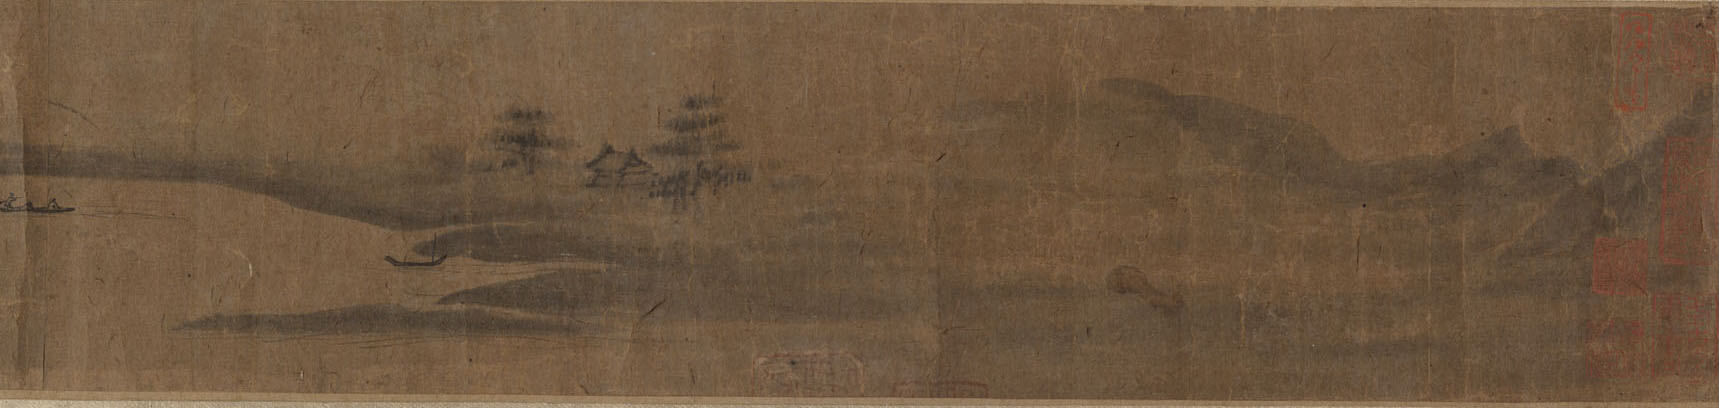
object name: handscroll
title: Miniature Landscape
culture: chinese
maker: unidentified artist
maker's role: artist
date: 1368-1911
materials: ink, paper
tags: landscapes